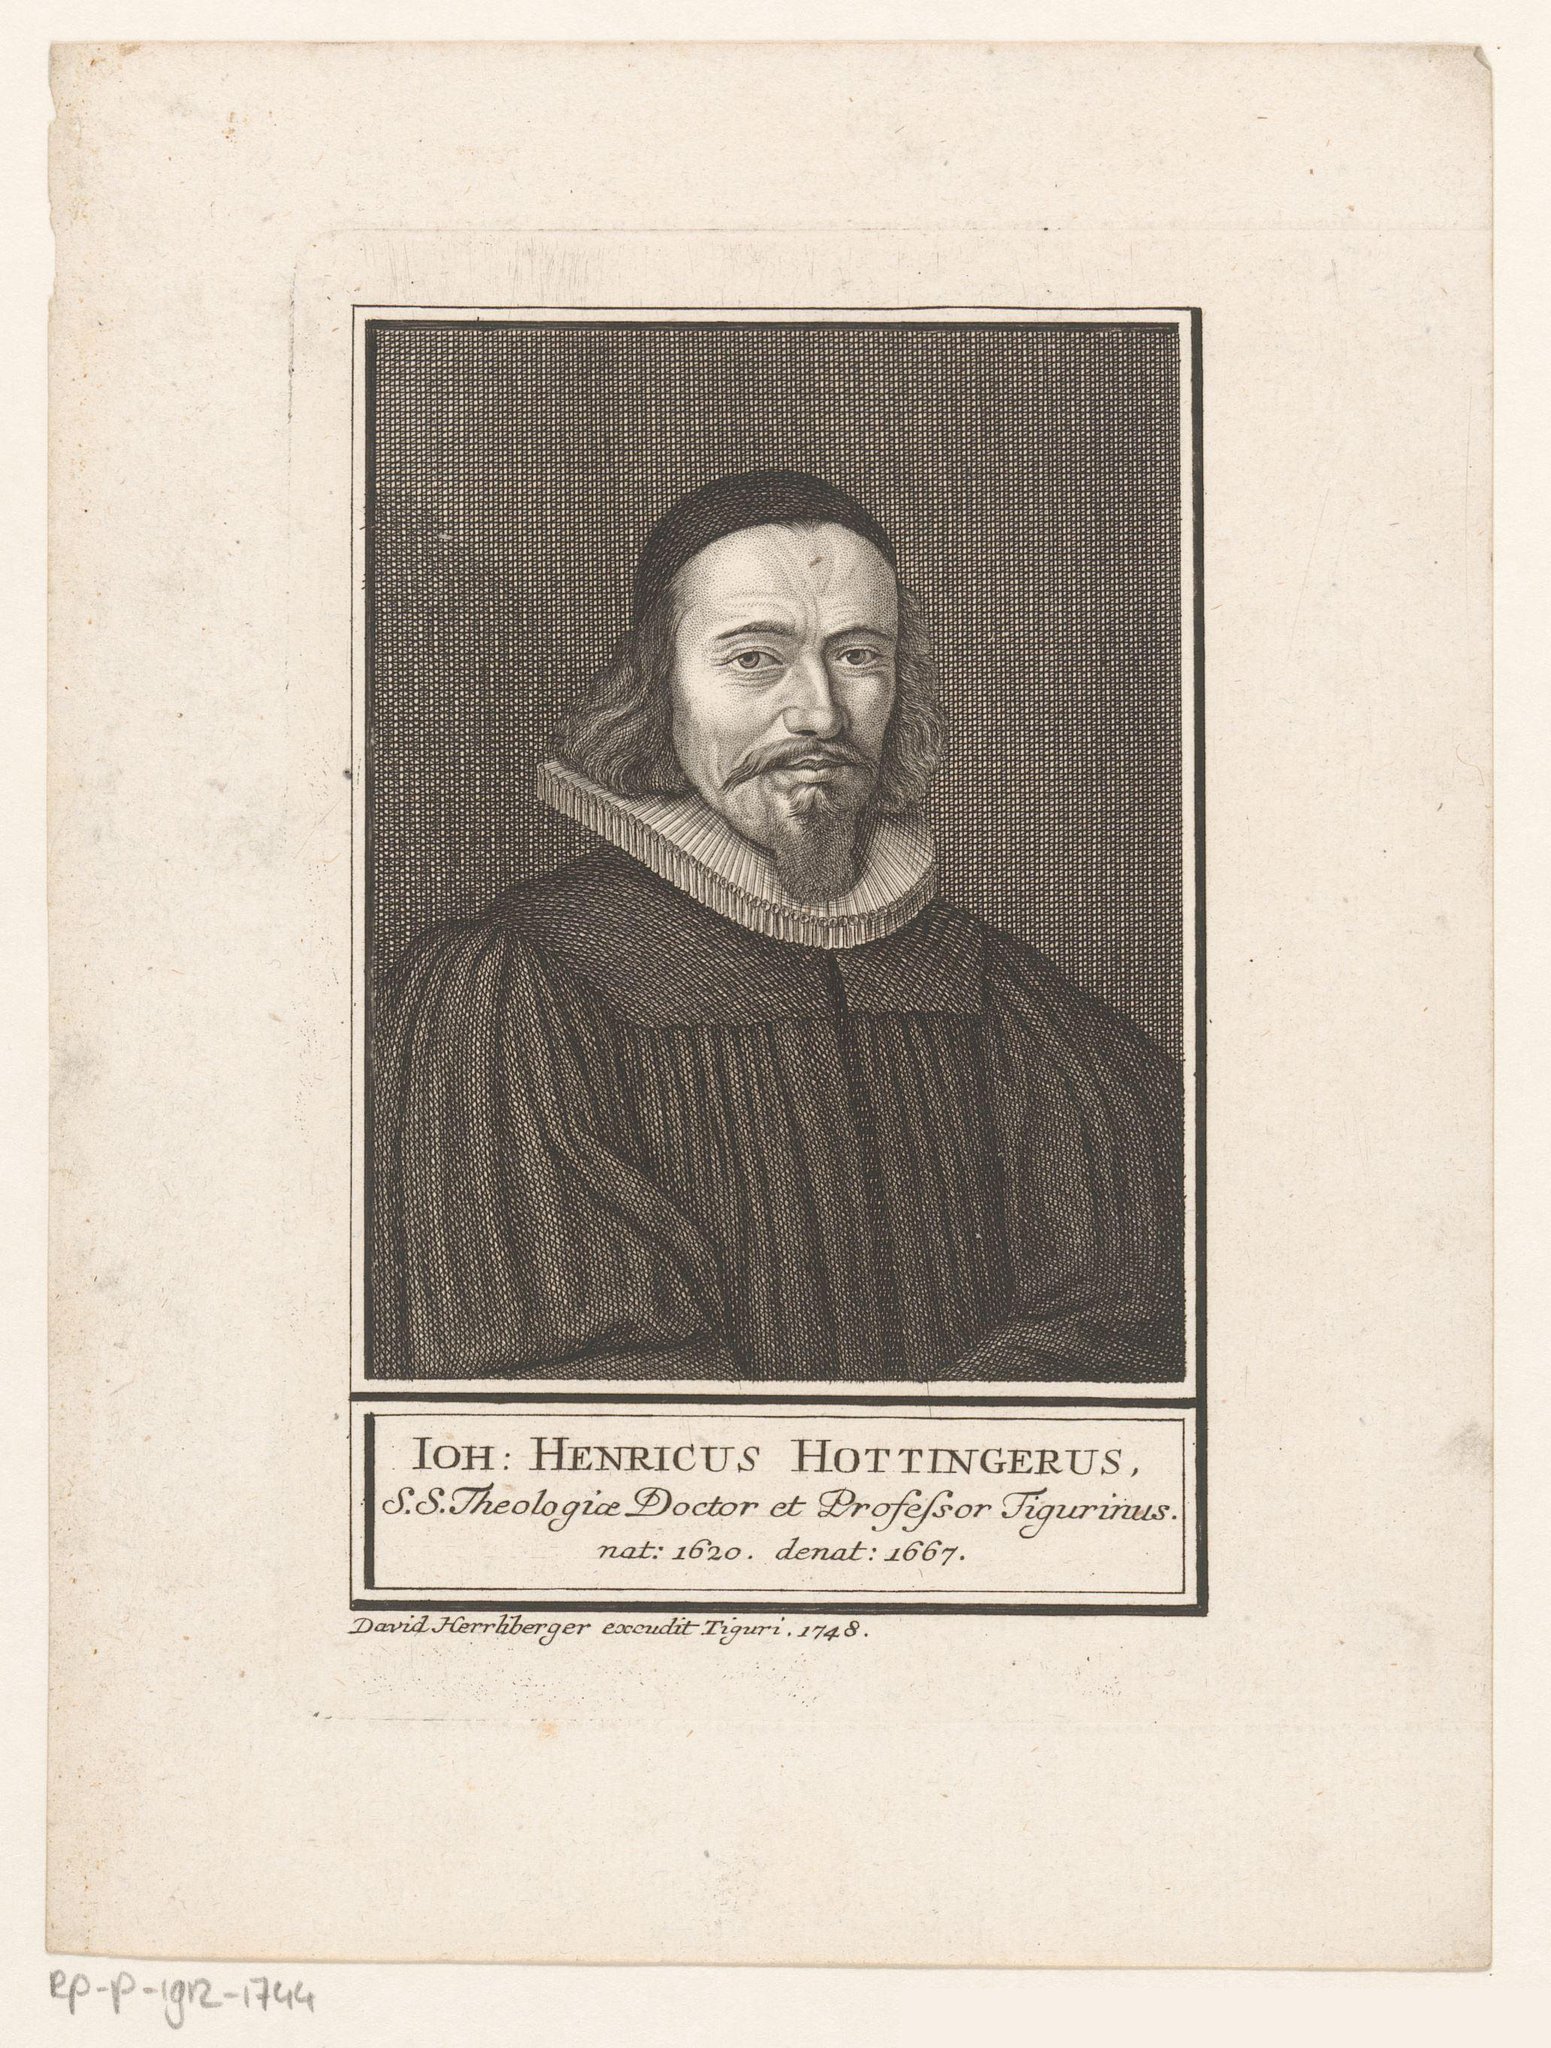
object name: print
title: Portret van Johann Heinrich Hottinger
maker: david herrliberger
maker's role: print maker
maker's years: 1697-1777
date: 1748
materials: paper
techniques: engraving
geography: zurich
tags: historical persons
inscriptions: collector's mark: Lugt 2228